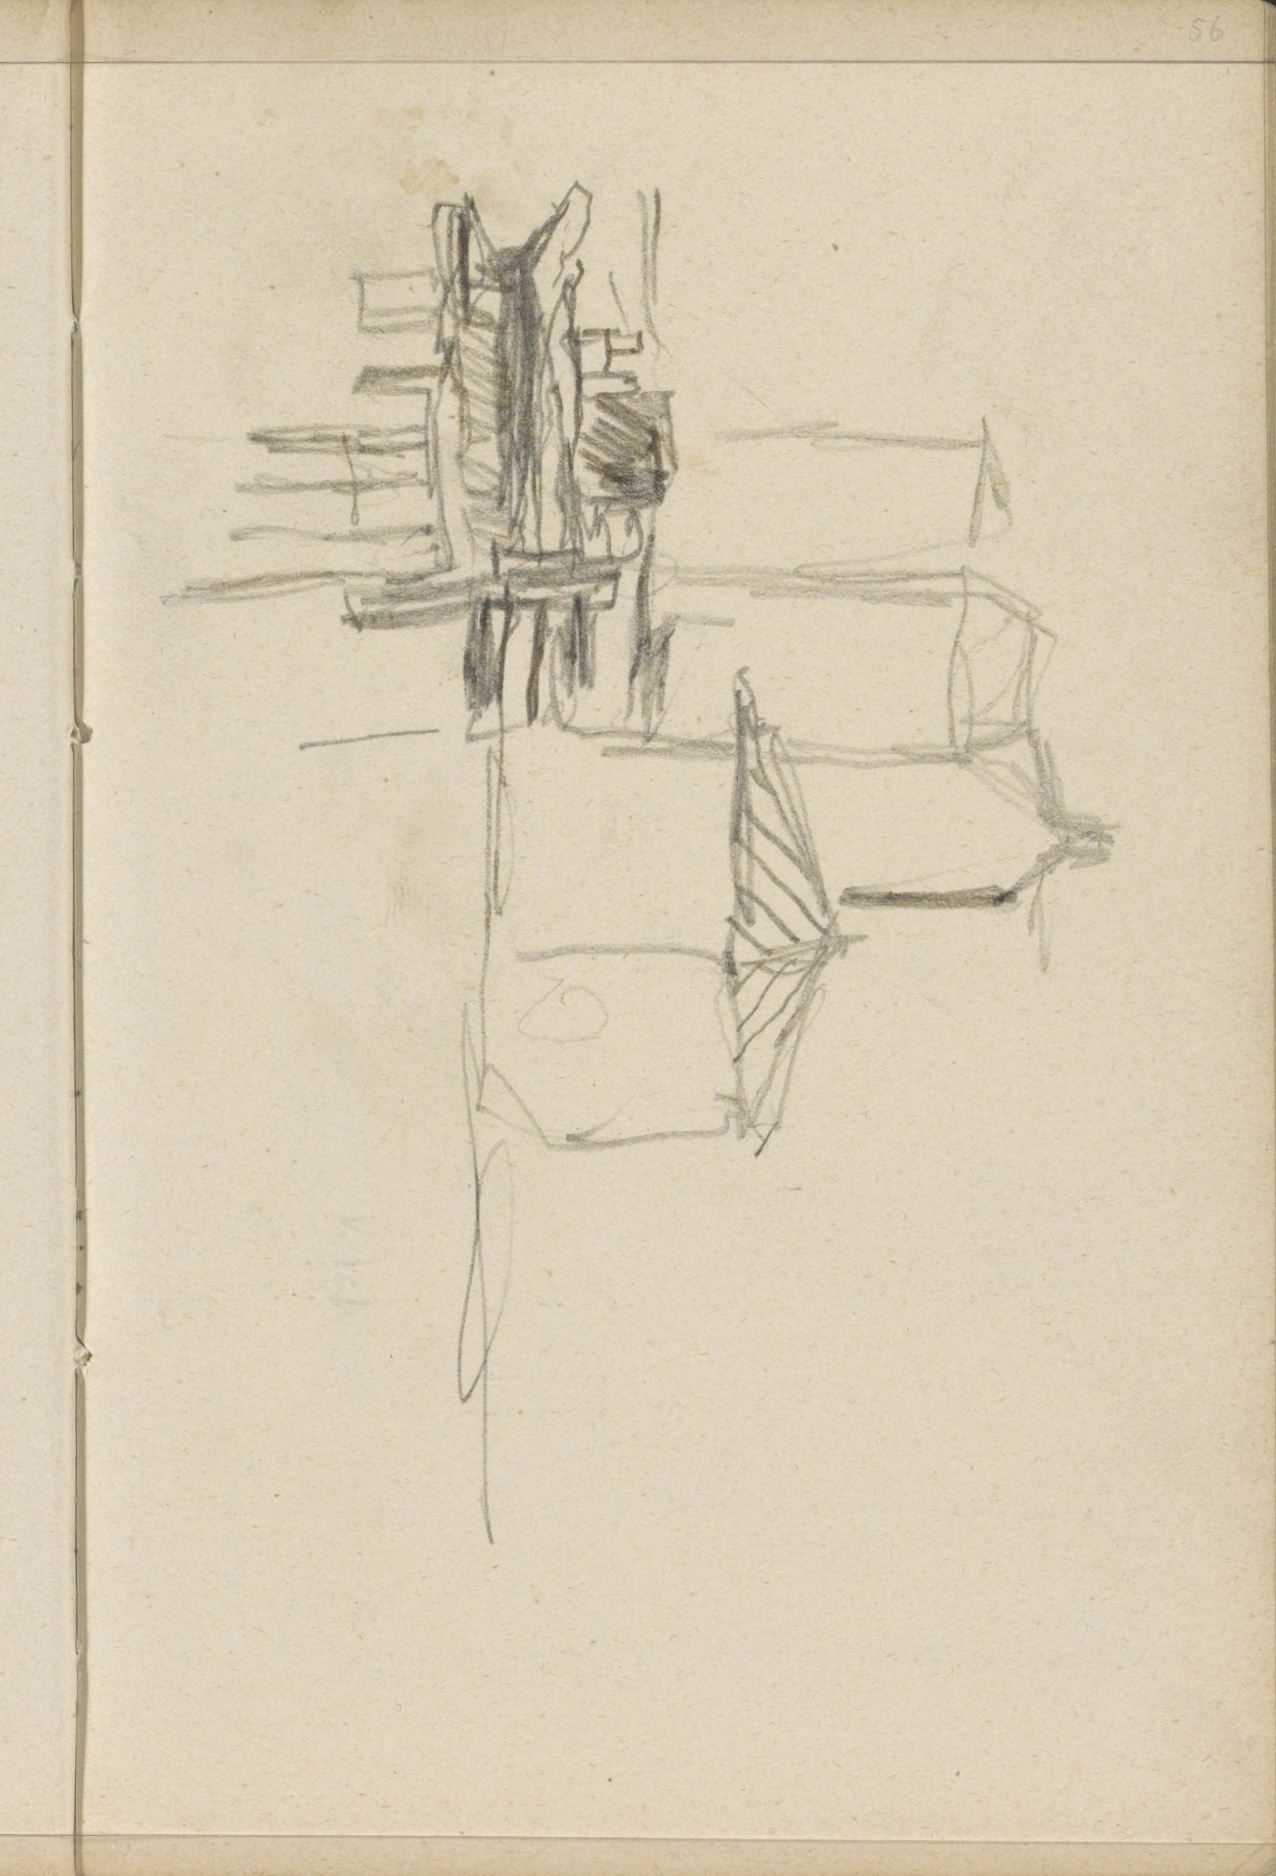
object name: sketchbook leaf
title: Gezicht te Amsterdam, mogelijk het Damrak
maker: george hendrik breitner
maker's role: draughtsman, painter, print maker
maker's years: 1857-1923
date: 1909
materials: paper, pencil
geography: amsterdam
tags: ships (in general), civic architecture; edifices; dwellings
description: Gezicht te Amsterdam, mogelijk het Damrak. Links een aangemeerde boot. Pagina 56 uit een schetsboek met 45 bladen vervaardigd in Amsterdam en Pittsburgh.